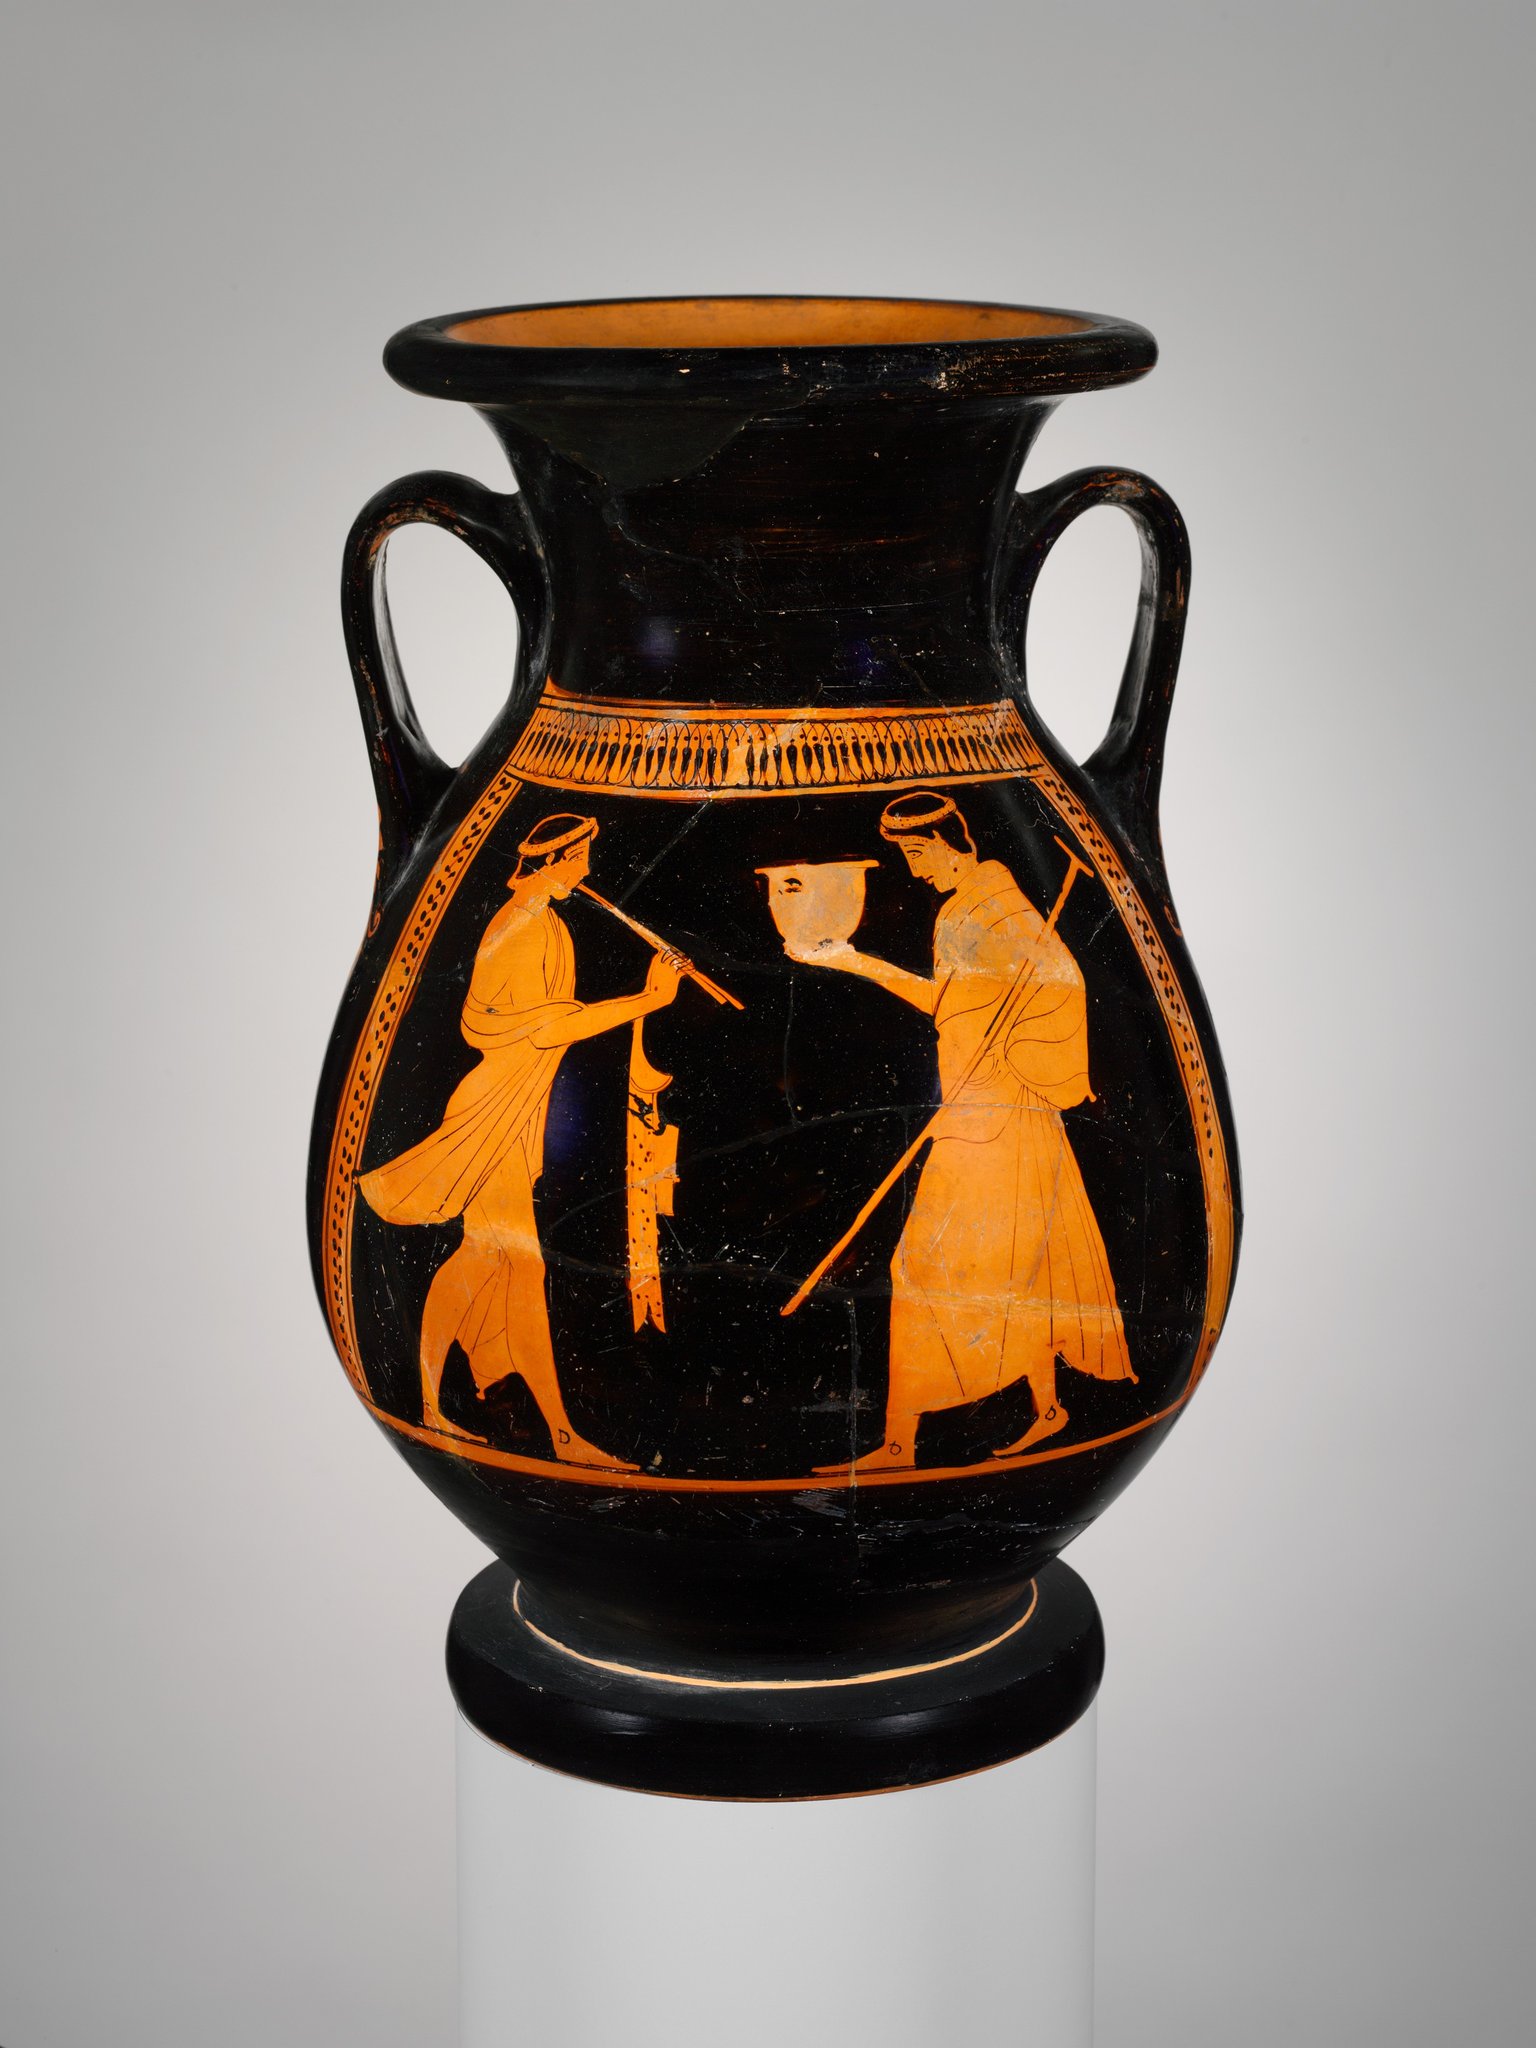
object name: pelike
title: Terracotta pelike (jar)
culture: greek, attic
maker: mannerists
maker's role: artist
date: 430 BCE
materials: terracotta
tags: men,flutes,musicians